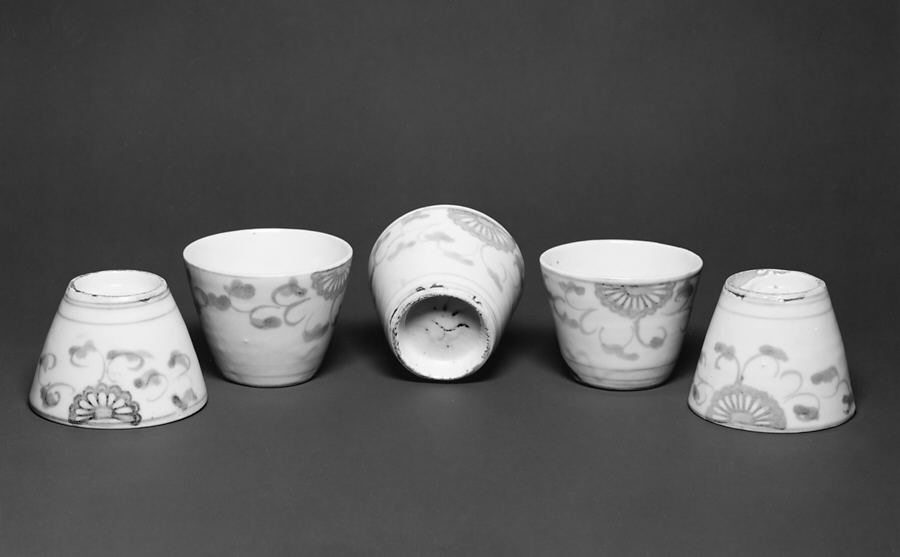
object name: soba cup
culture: japanese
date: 1801-1900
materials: cobalt, porcelain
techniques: painting, underglaze